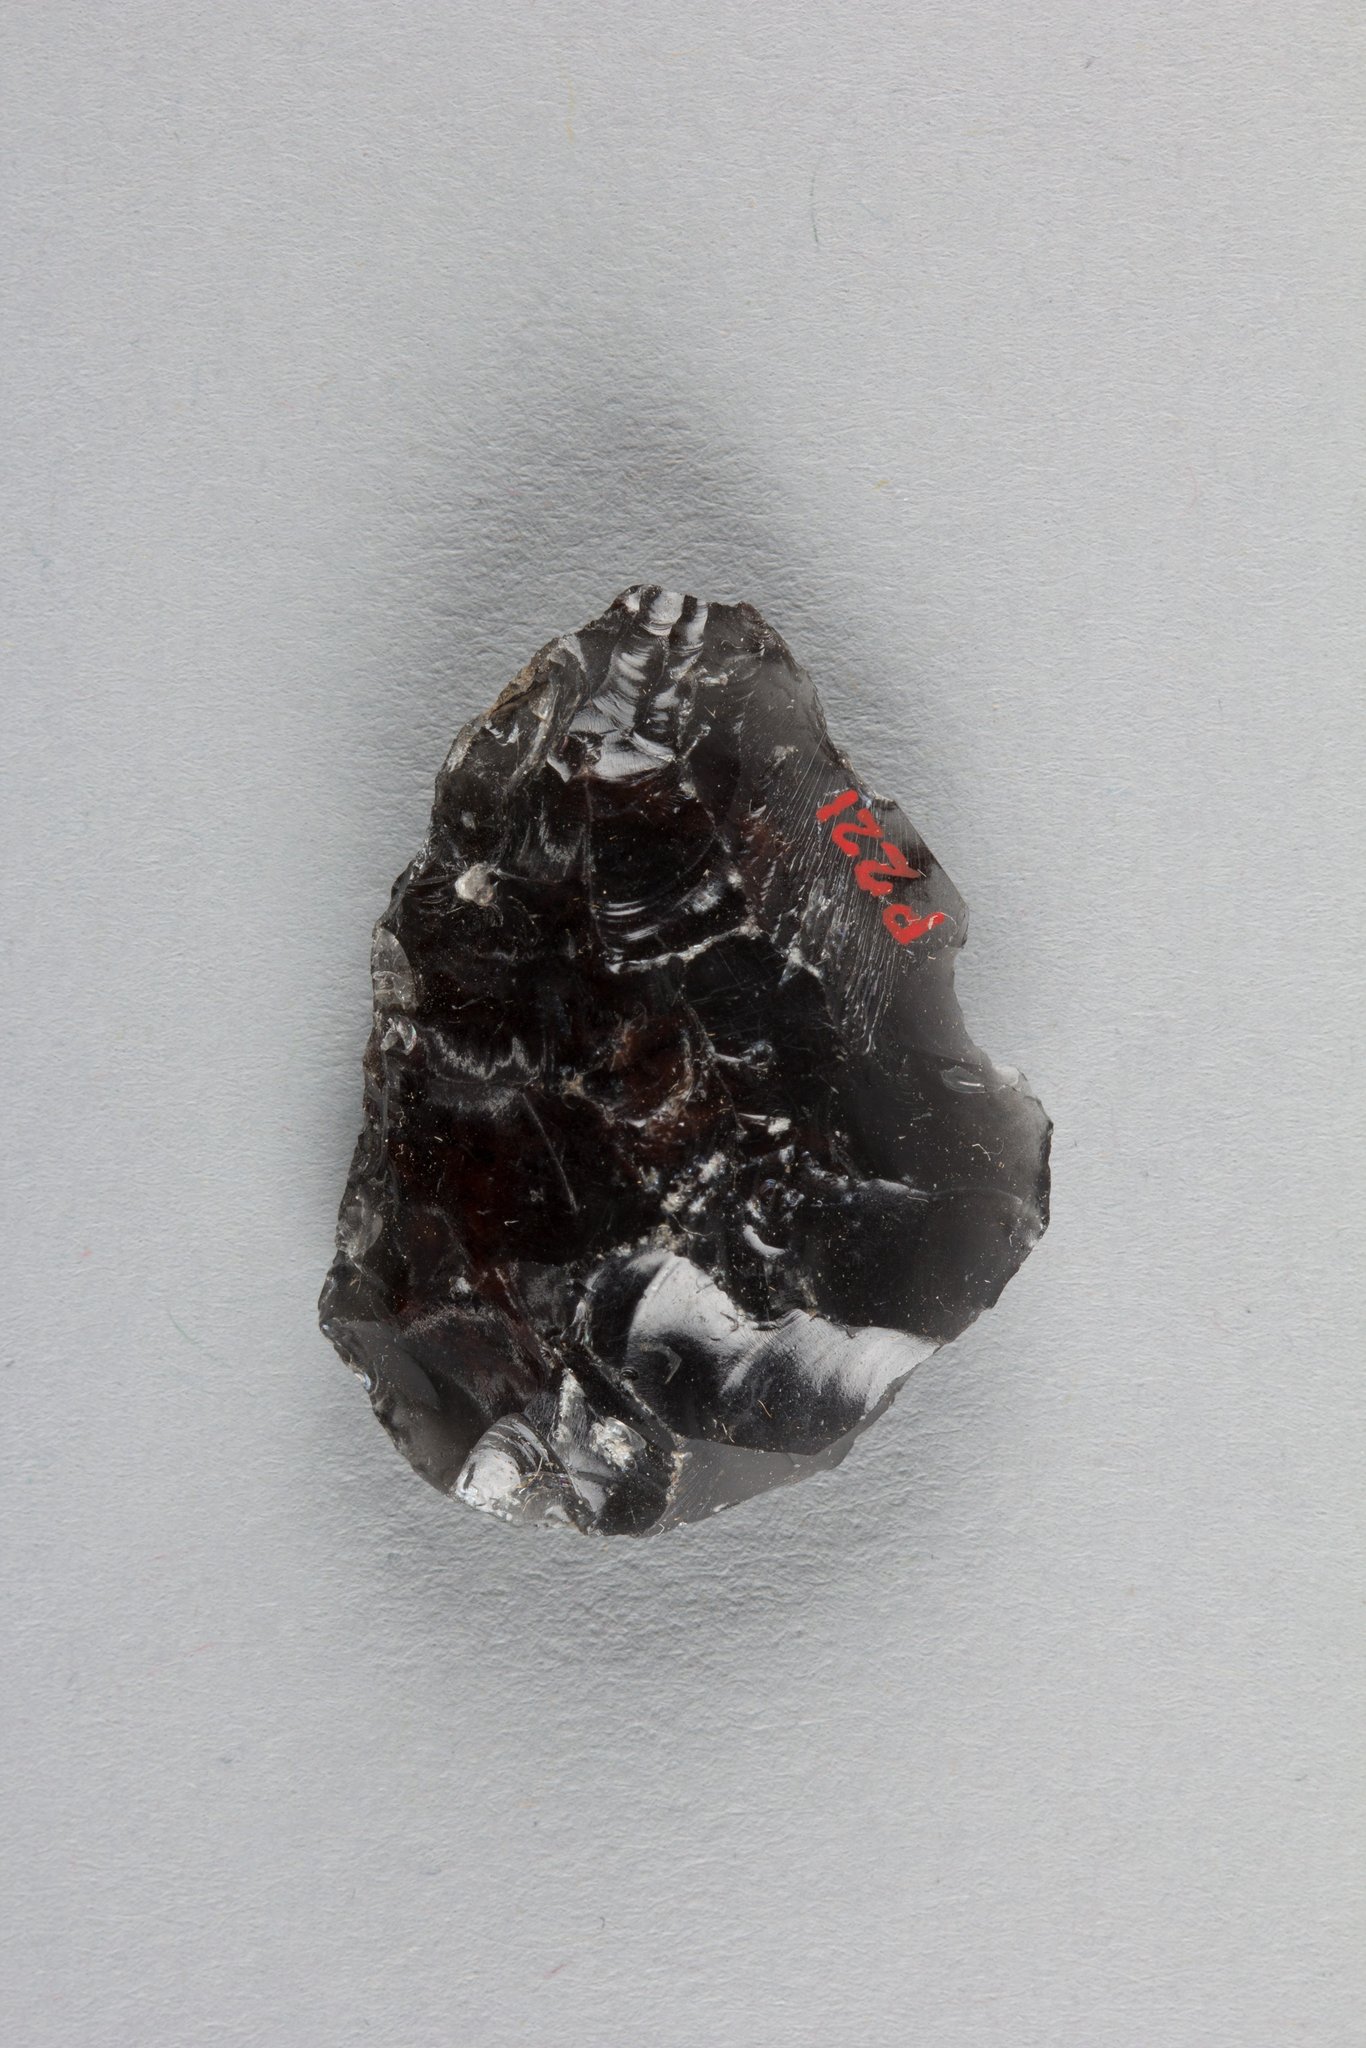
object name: arrowhead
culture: japanese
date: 1500-1000 BCE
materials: stone